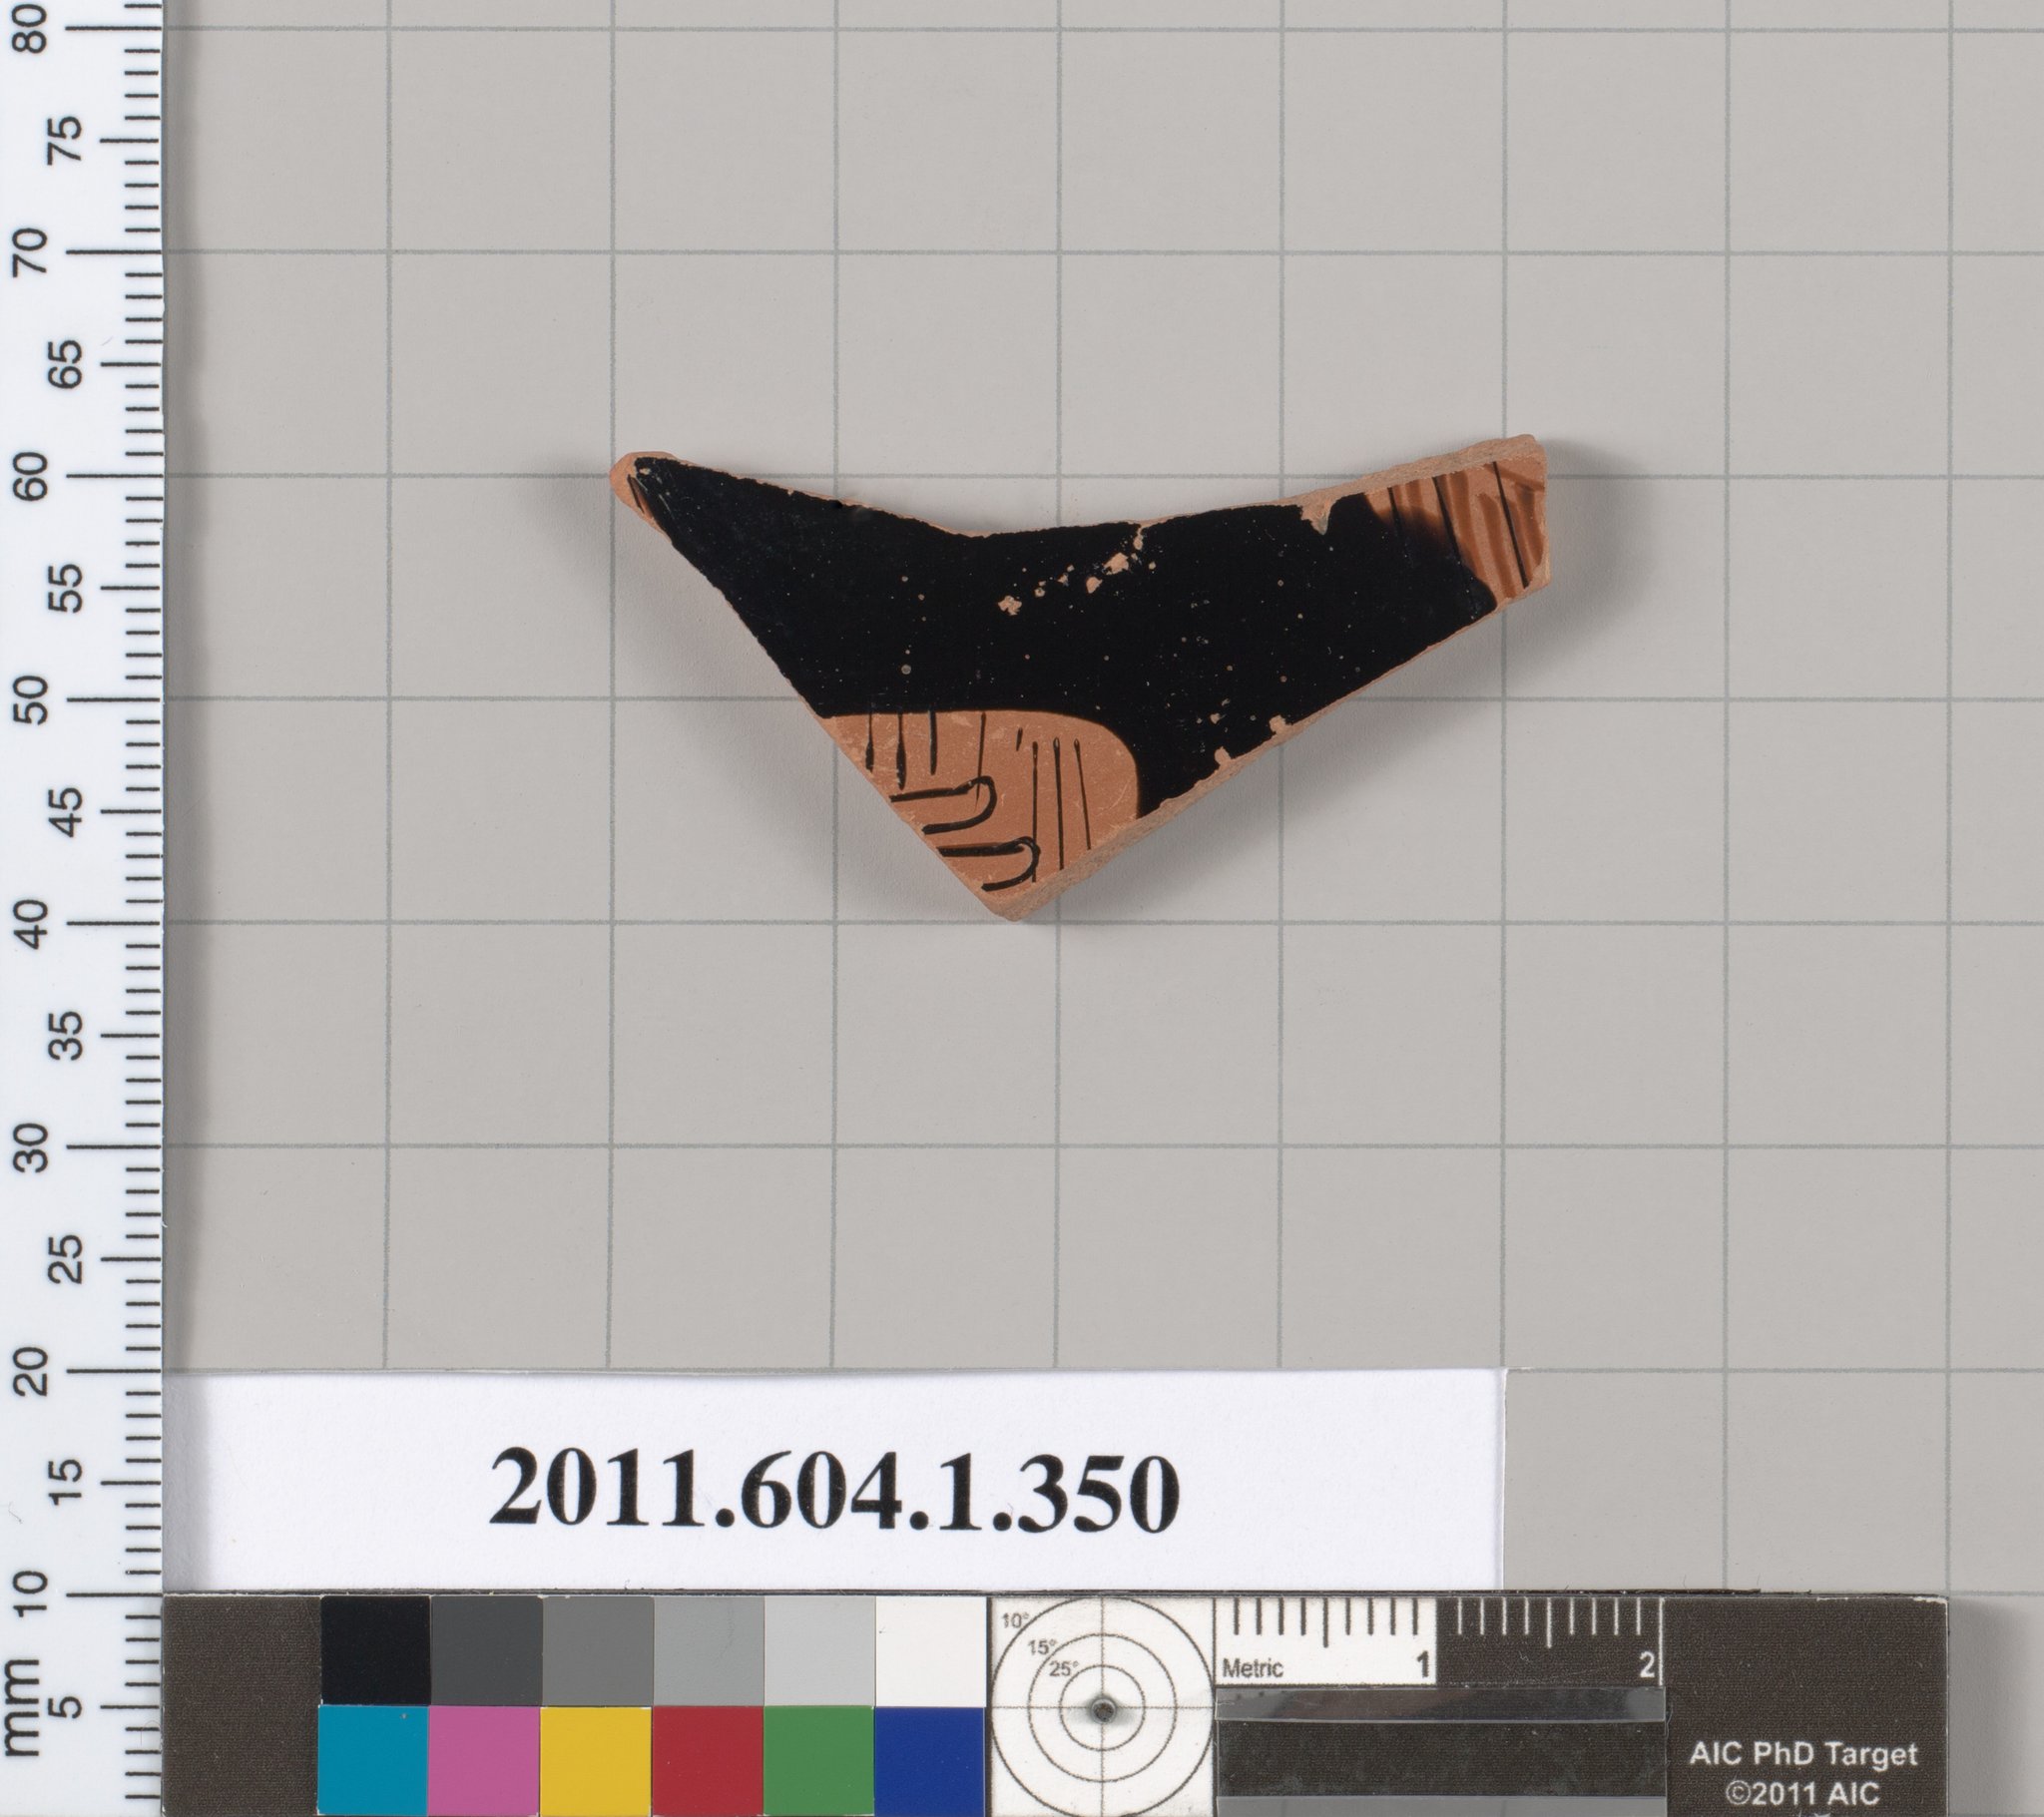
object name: kylix fragment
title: Terracotta fragment of a kylix (drinking cup)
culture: greek, attic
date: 475-451 BCE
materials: terracotta